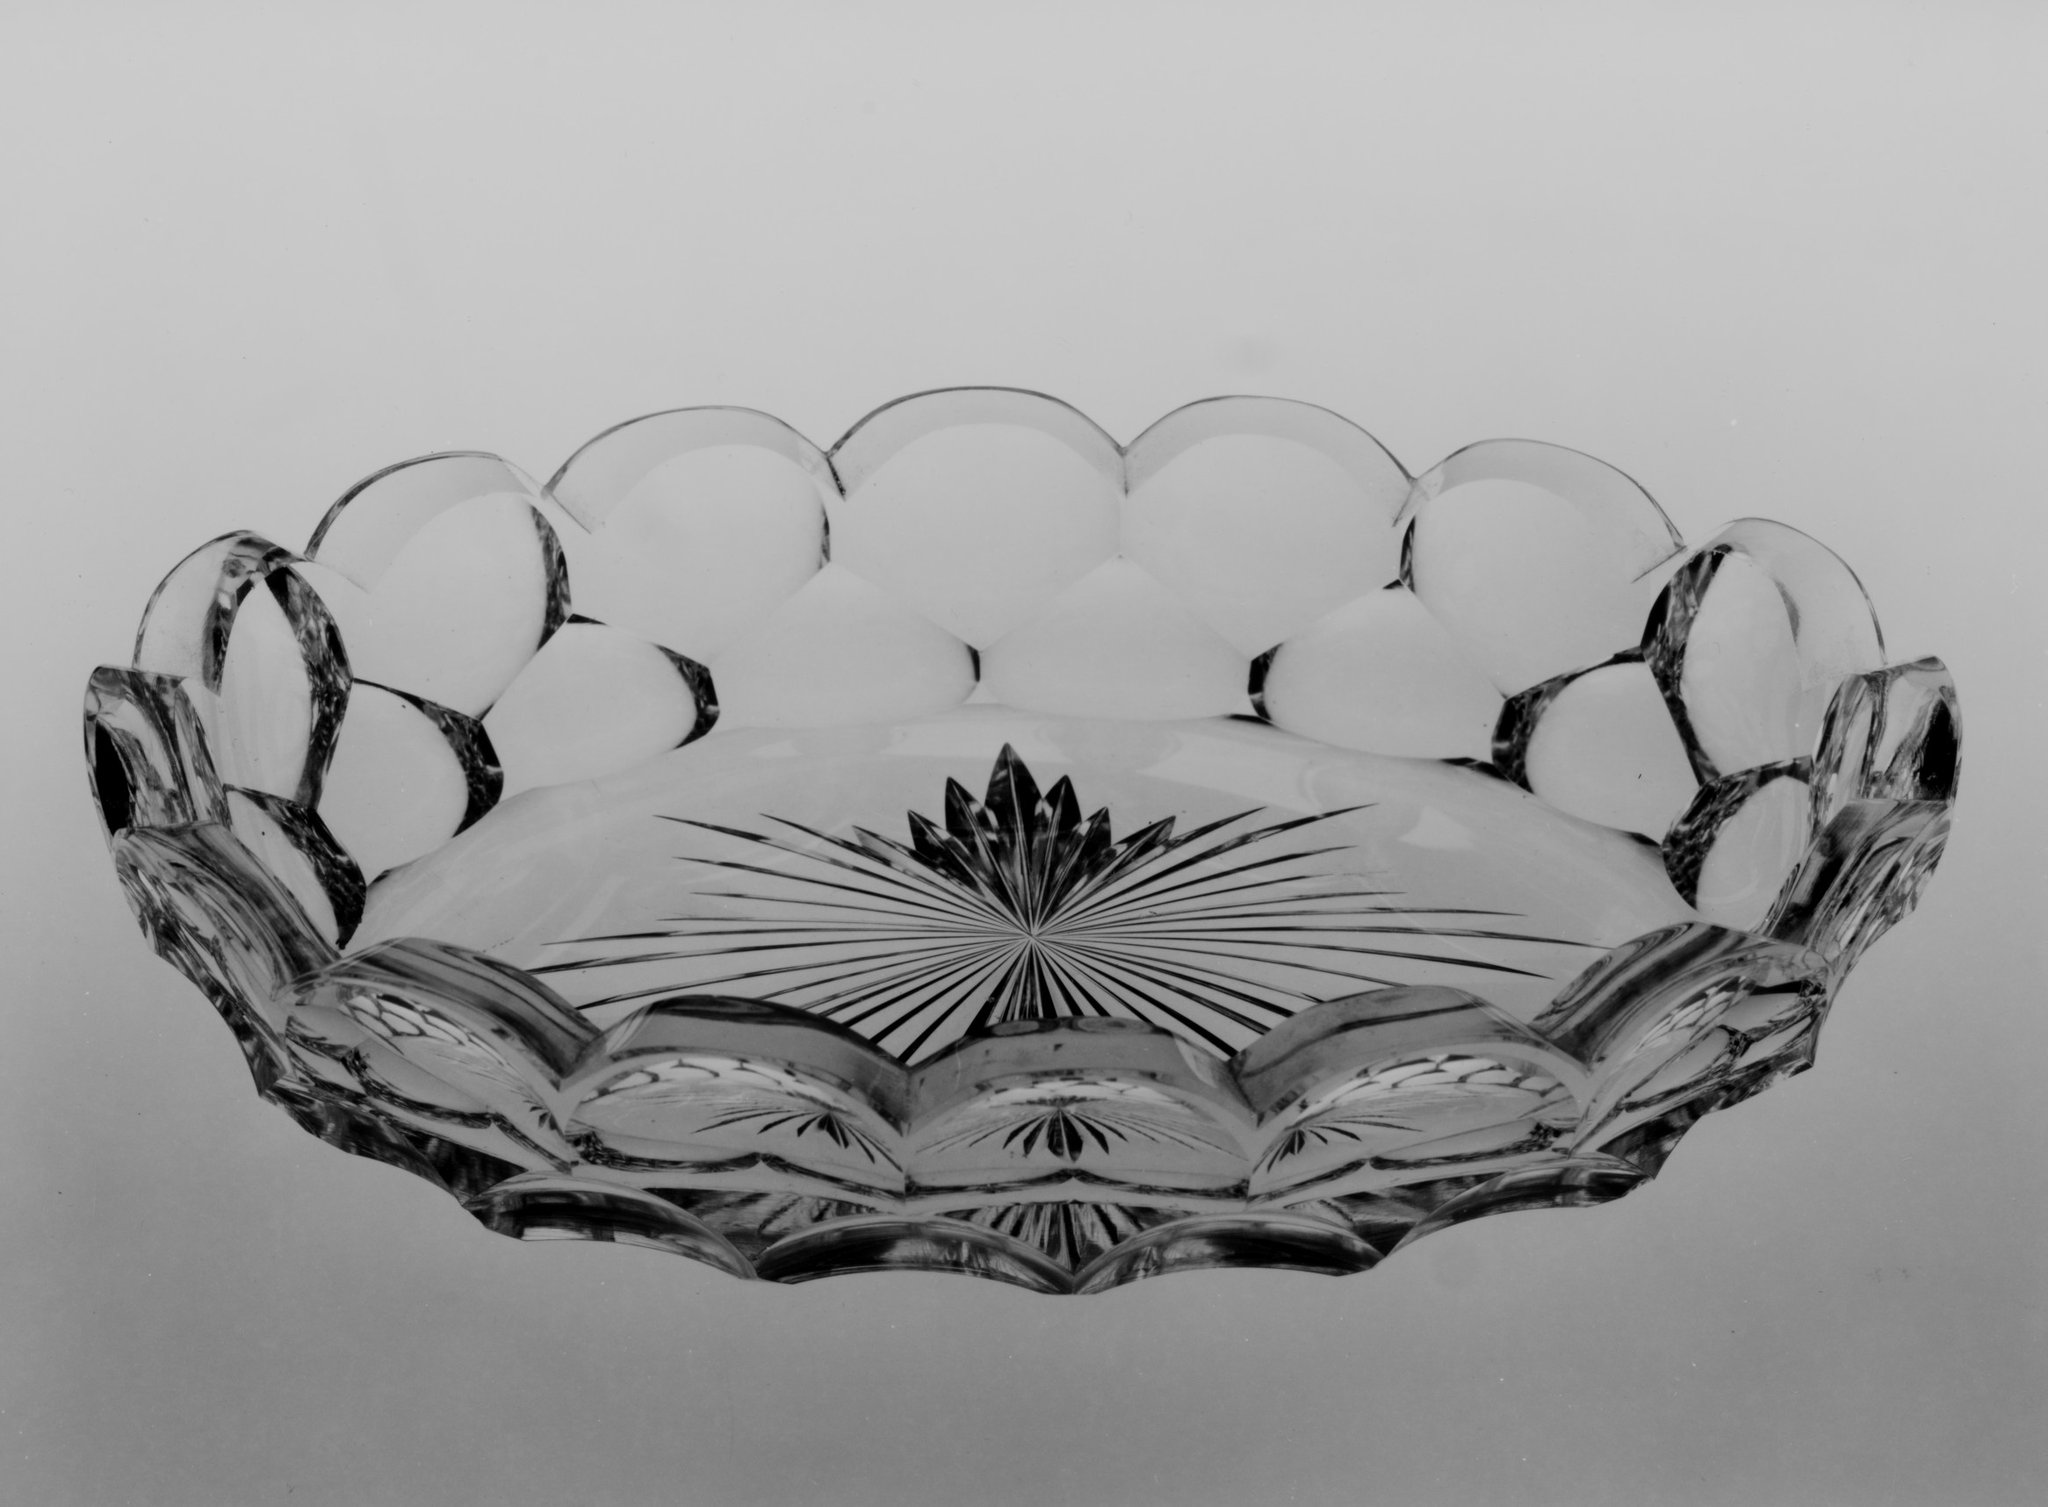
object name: dish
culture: american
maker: hobbs, brockunier and company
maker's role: maker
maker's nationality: american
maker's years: 1863-1891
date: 1860-1880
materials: glass, lead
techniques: glassblowing, cutting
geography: united states